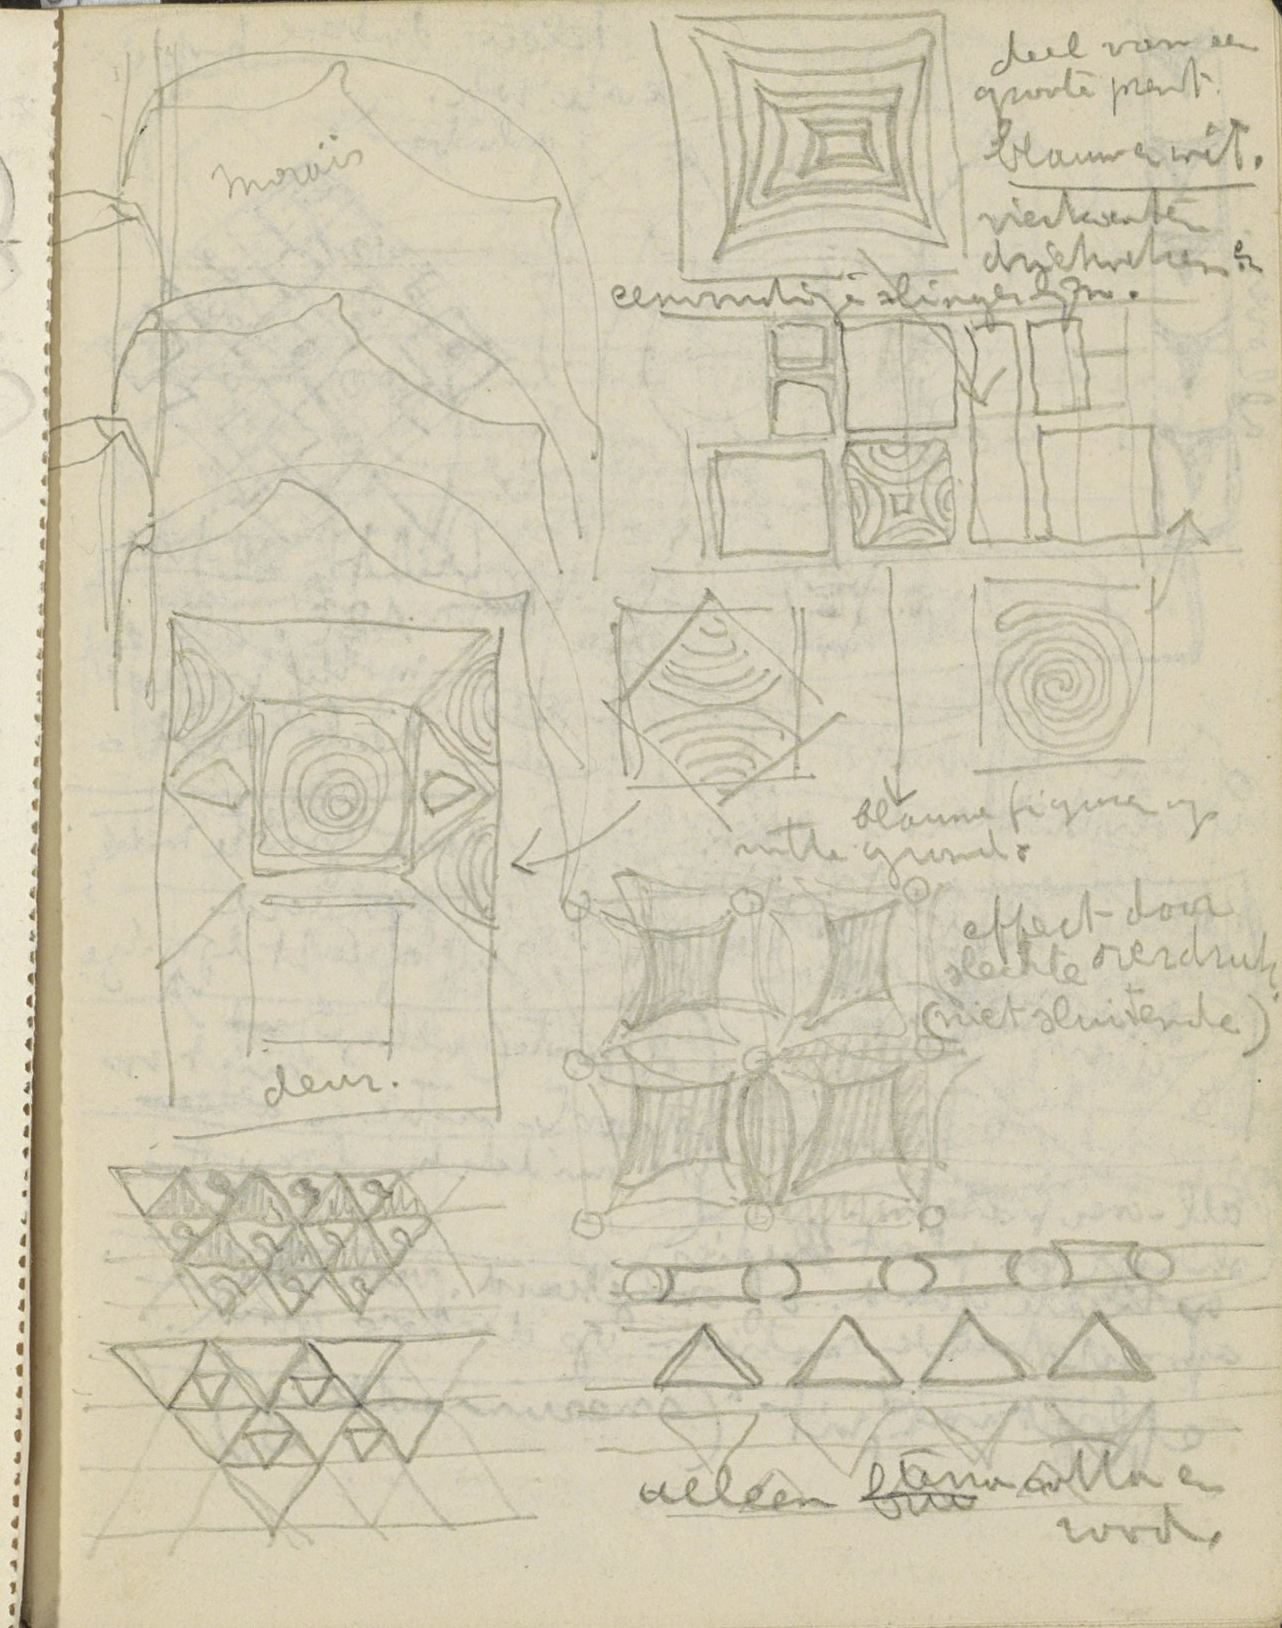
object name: sketchbook leaf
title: Deur en decoratieve patronen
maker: reijer stolk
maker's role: draughtsman, print maker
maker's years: 1896-1945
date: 1916-1945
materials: paper, pencil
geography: africa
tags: ornaments ~ art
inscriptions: kleurnotitie, handgeschreven in potlood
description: Onder andere patronen met slingers, vierkanten en driehoeken. Blad 55 recto uit een schetsboek met 60 bladen.